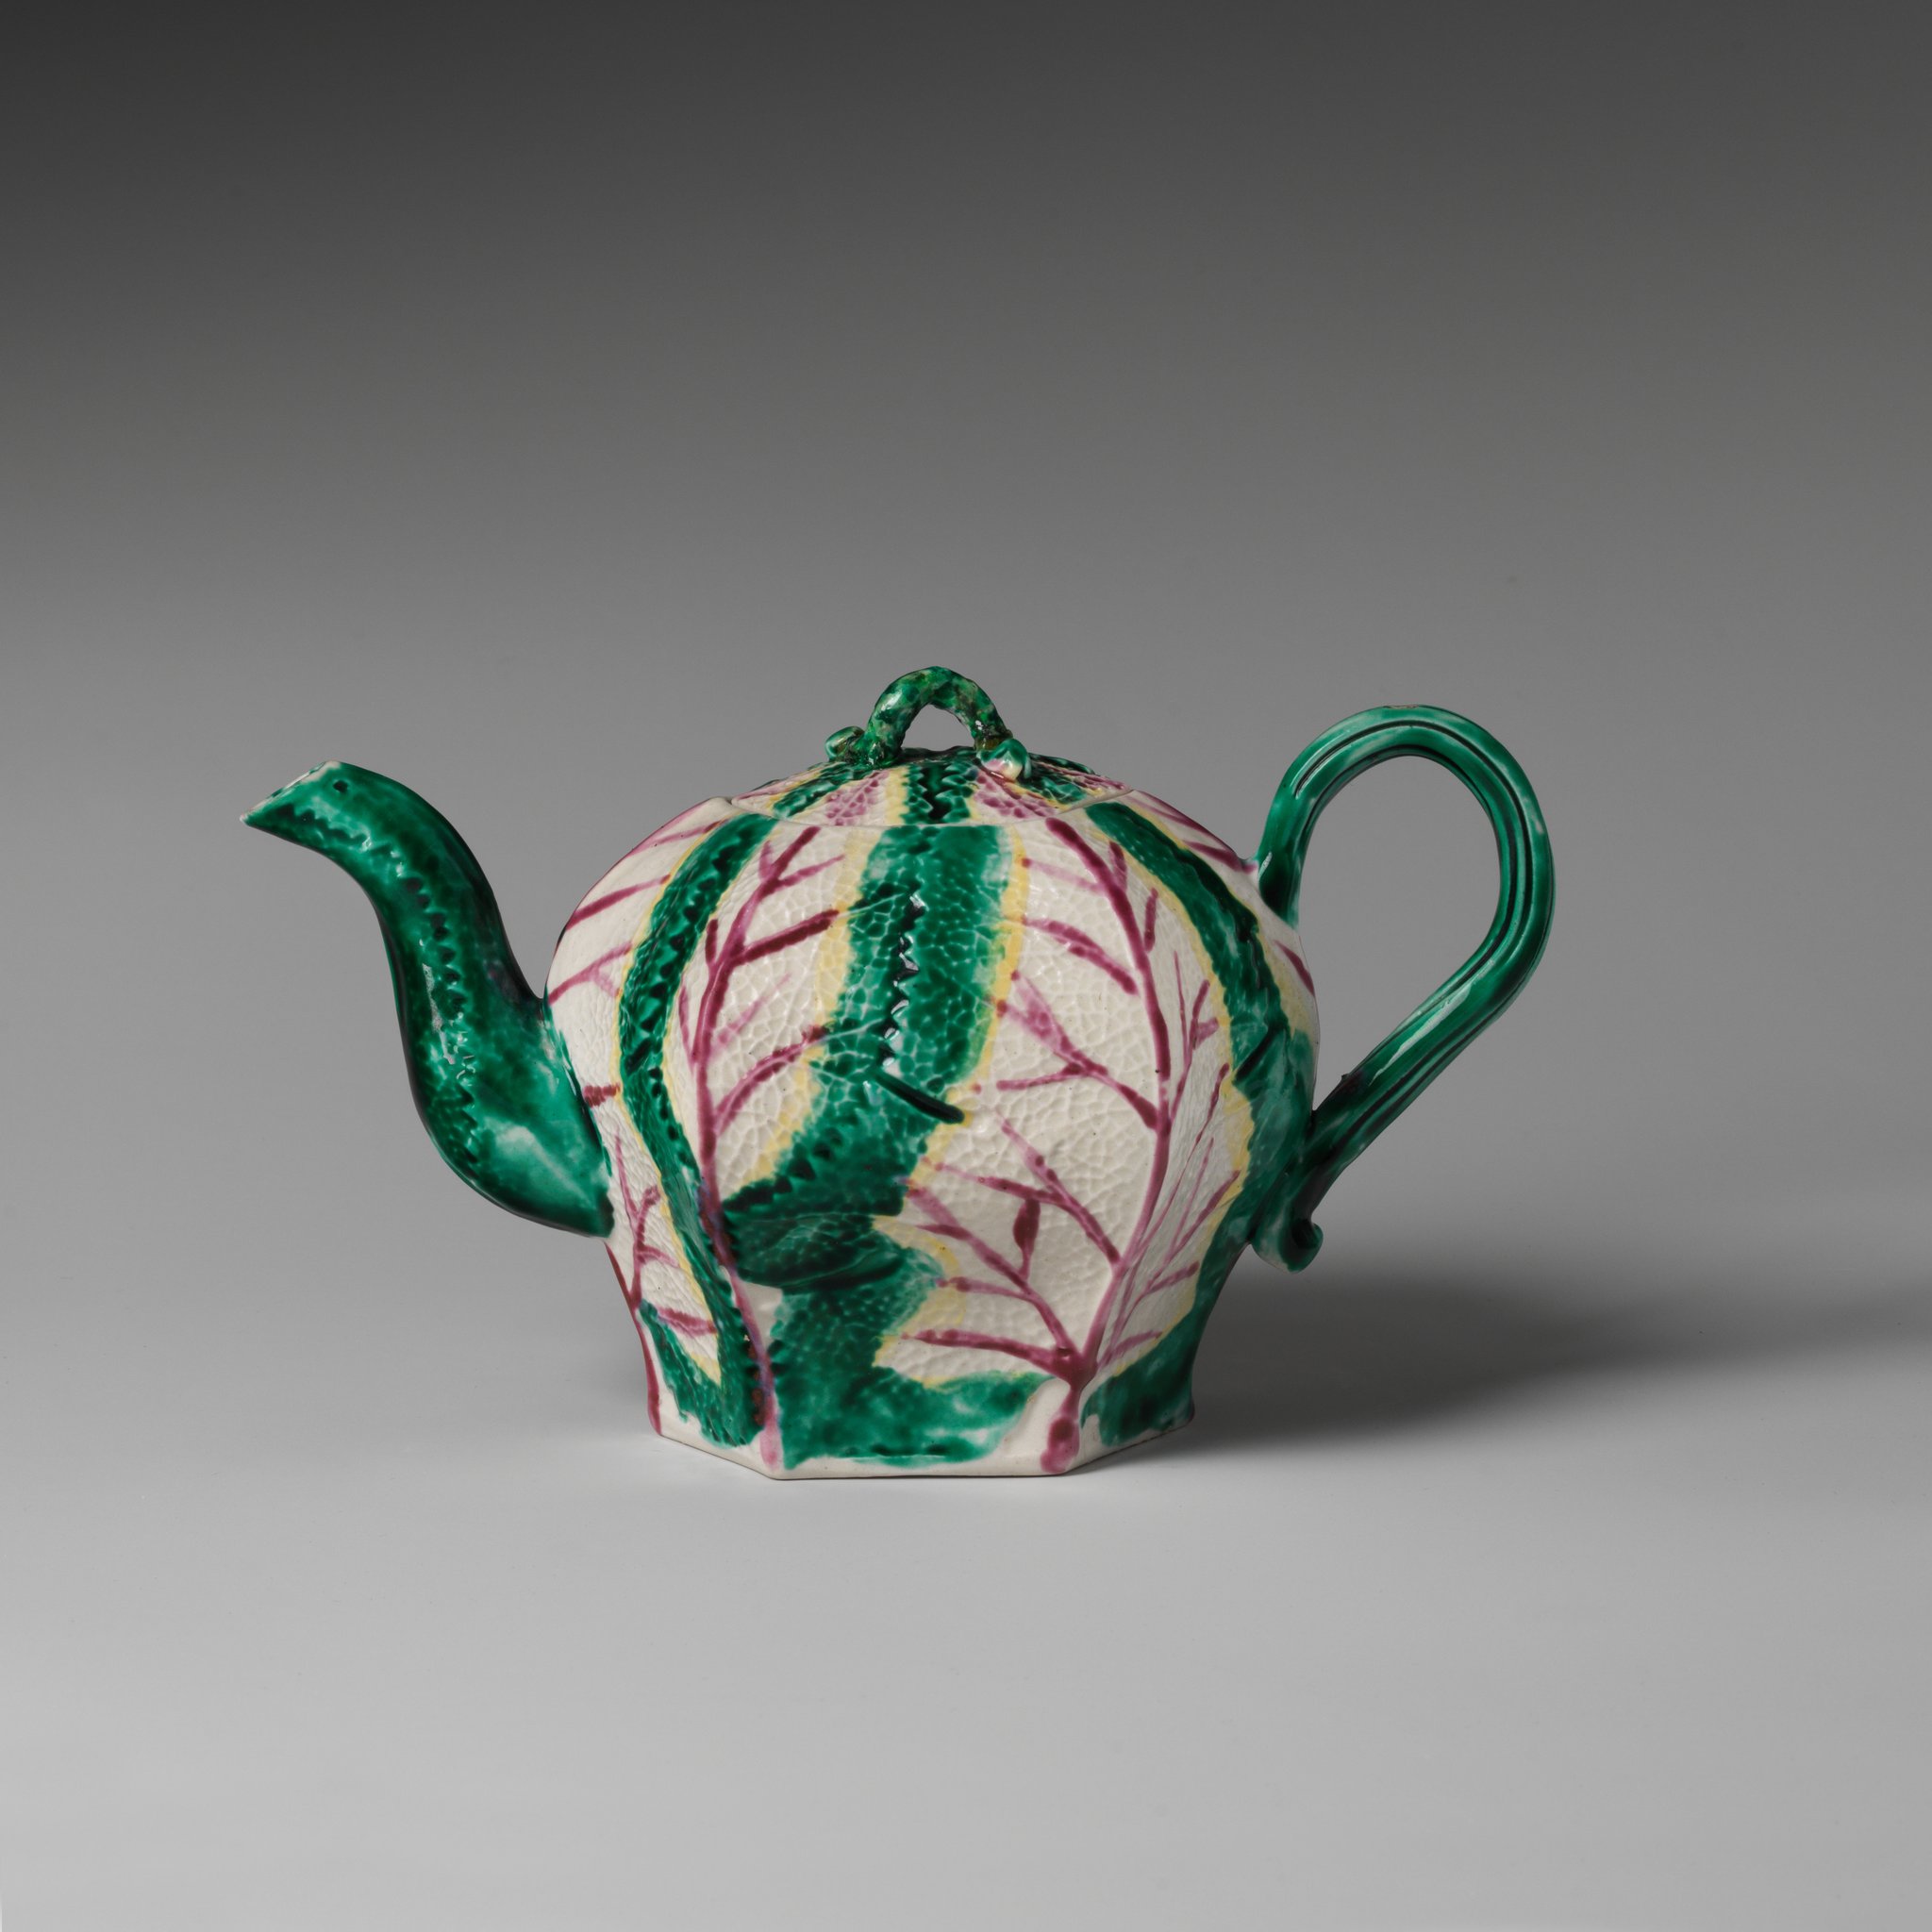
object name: teapot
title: Teapot in the form of a cabbage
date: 1760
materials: enamel, stoneware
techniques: salt glaze